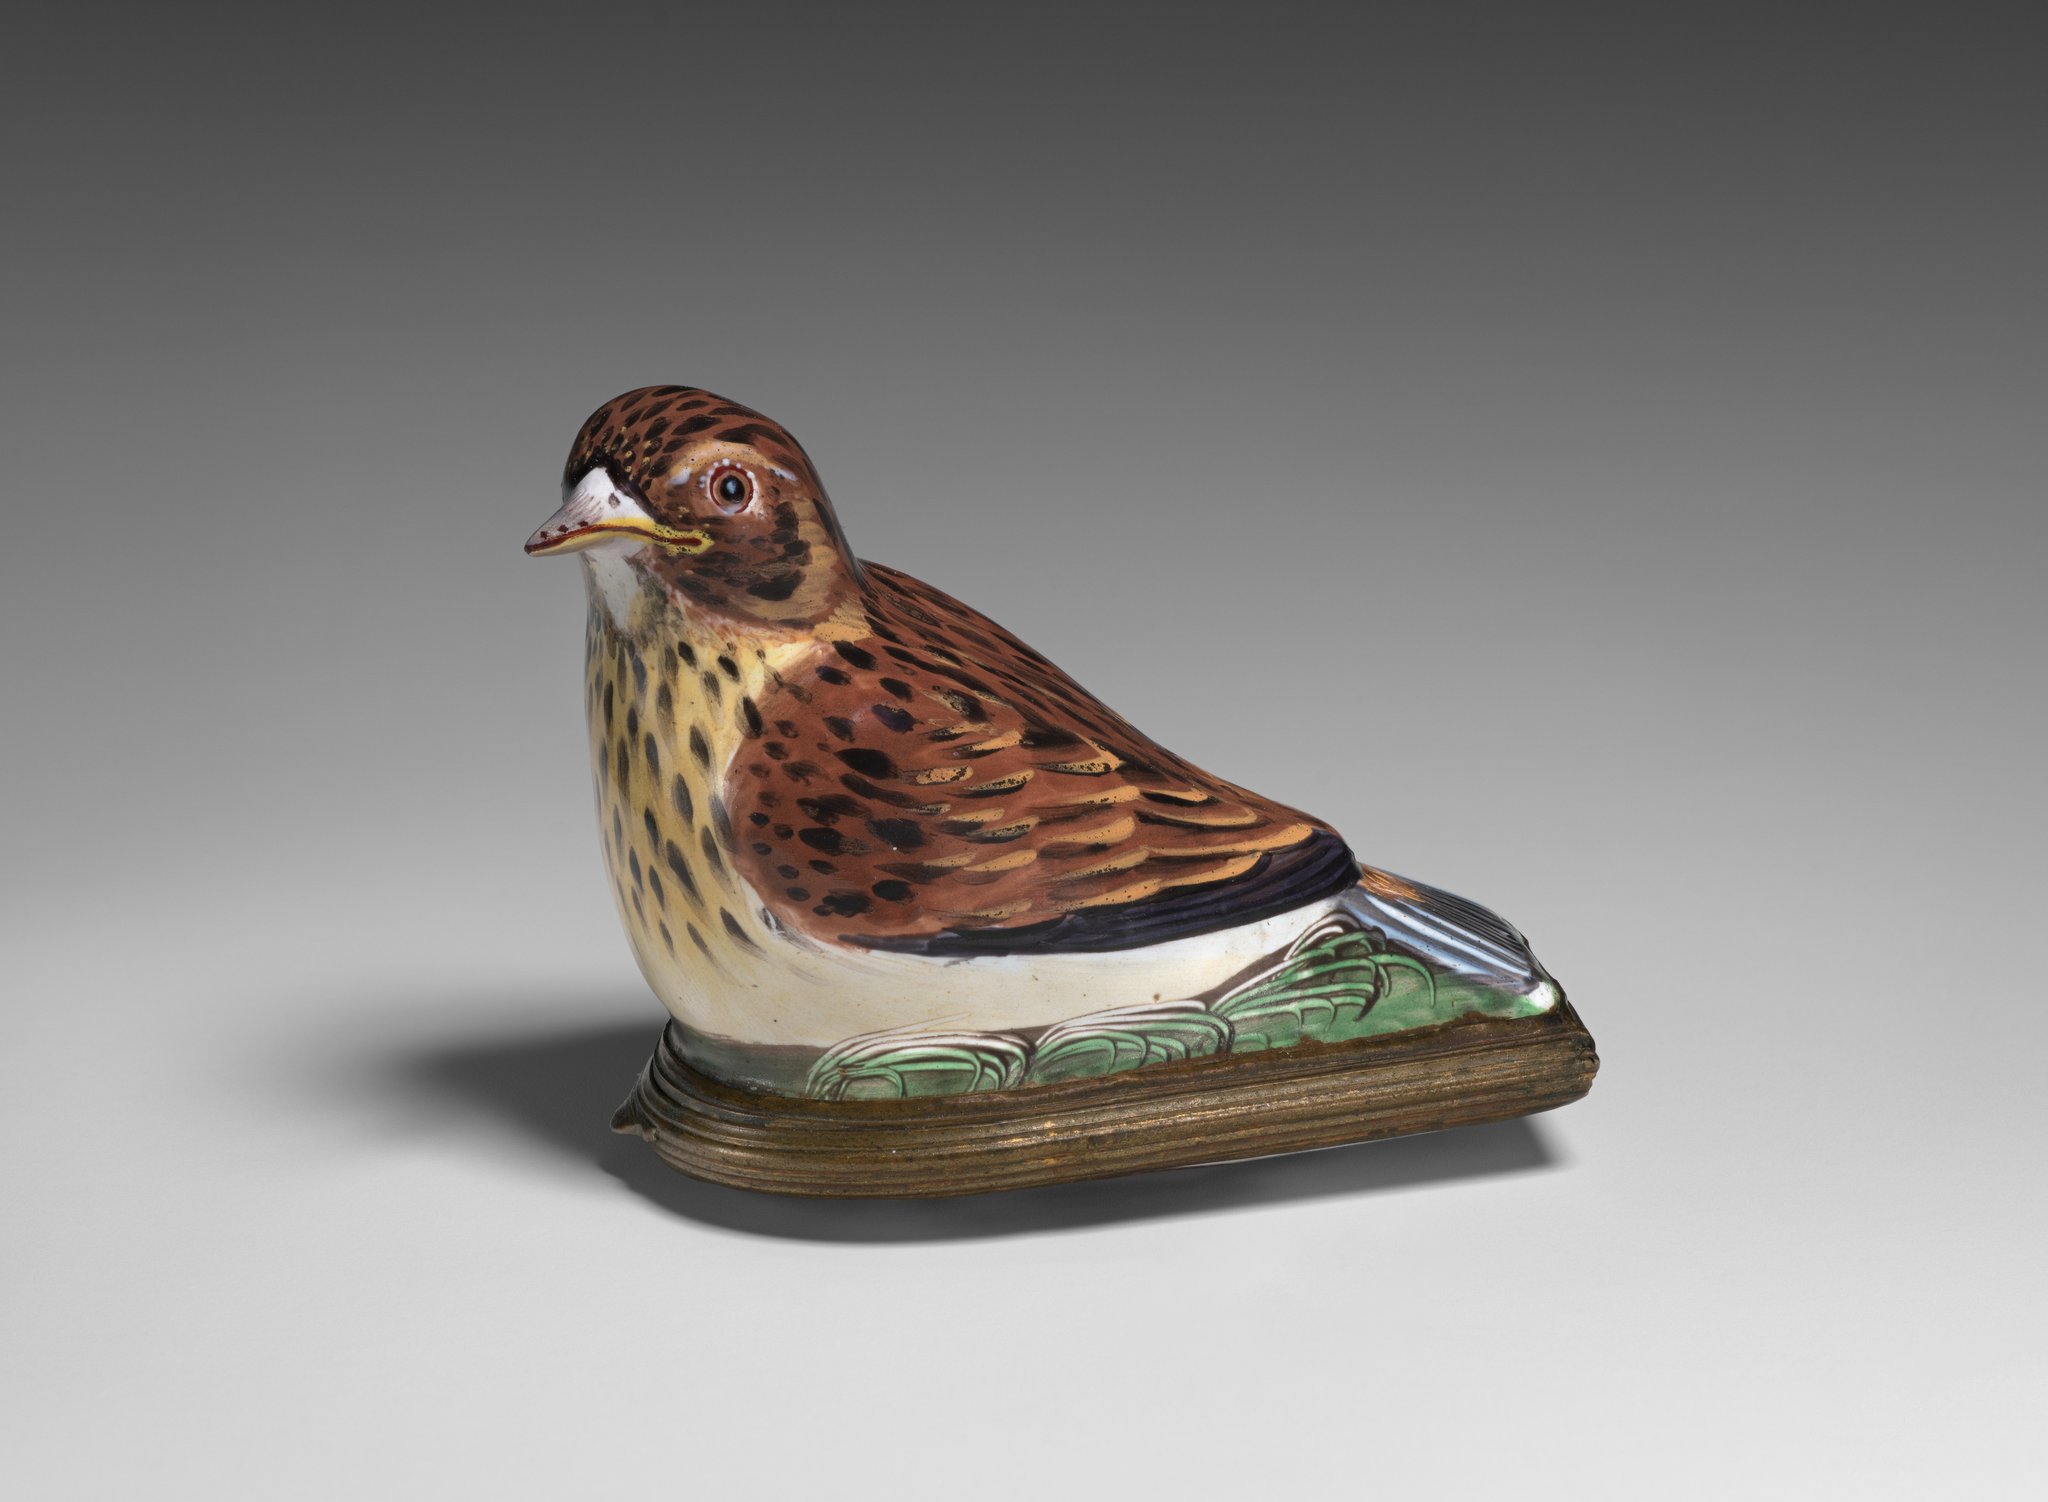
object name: bonbonnière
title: Bonbonnière in the form of a bird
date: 1770-1780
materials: copper, enamel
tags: birds